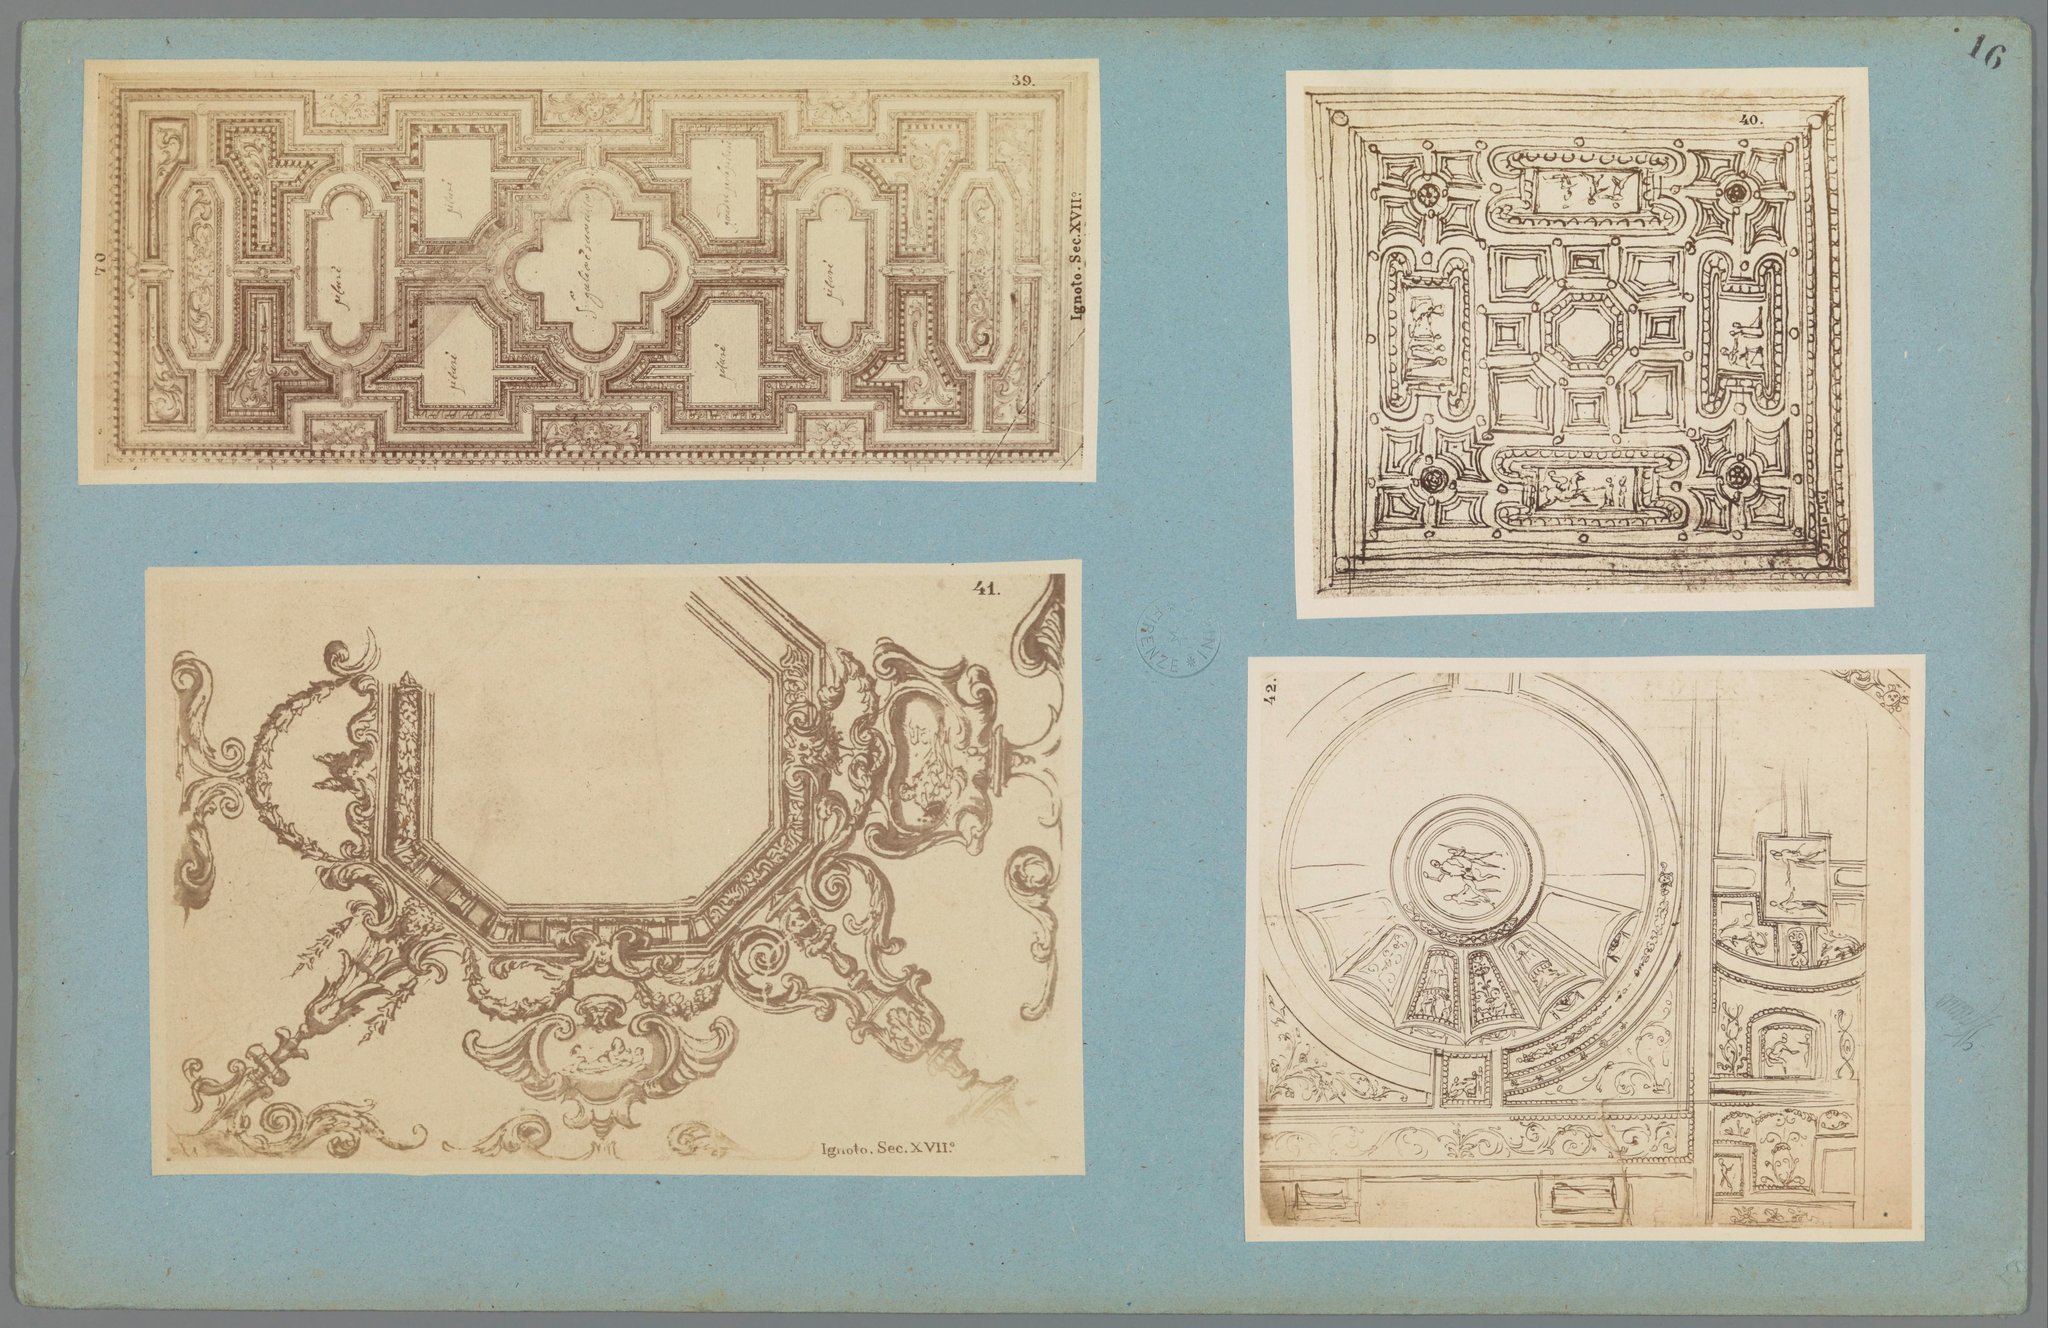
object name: photograph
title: Vier fotoreproducties van ontwerptekeningen voor plafonds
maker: Anonymous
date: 1875-1900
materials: cardboard, photographic support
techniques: albumen print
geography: europe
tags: ornament ~ arabesque, scrollwork, strapwork ~ ornament, (decorated) ceiling, europe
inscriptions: number: ‘41.’, number: ‘39.’, collector's mark: Lugt 3937, name: ‘C. PINI FIRENZE’, number: ‘16’, inscription: ‘Sec.XVIIo.’, inscription: ‘Sec.XVIIo.’, number: ‘42.’, number: ‘40.’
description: Linksboven (39) een ontwerptekening voor een cassetteplafond, linksonder (41) een ornamenttekening met rolwerk, rechtsboven (40) een ontwerptekening voor een cassettenplafond, rechtsonder (42) een ontwerptekening voor (vermoedelijk) een koepelplafond.